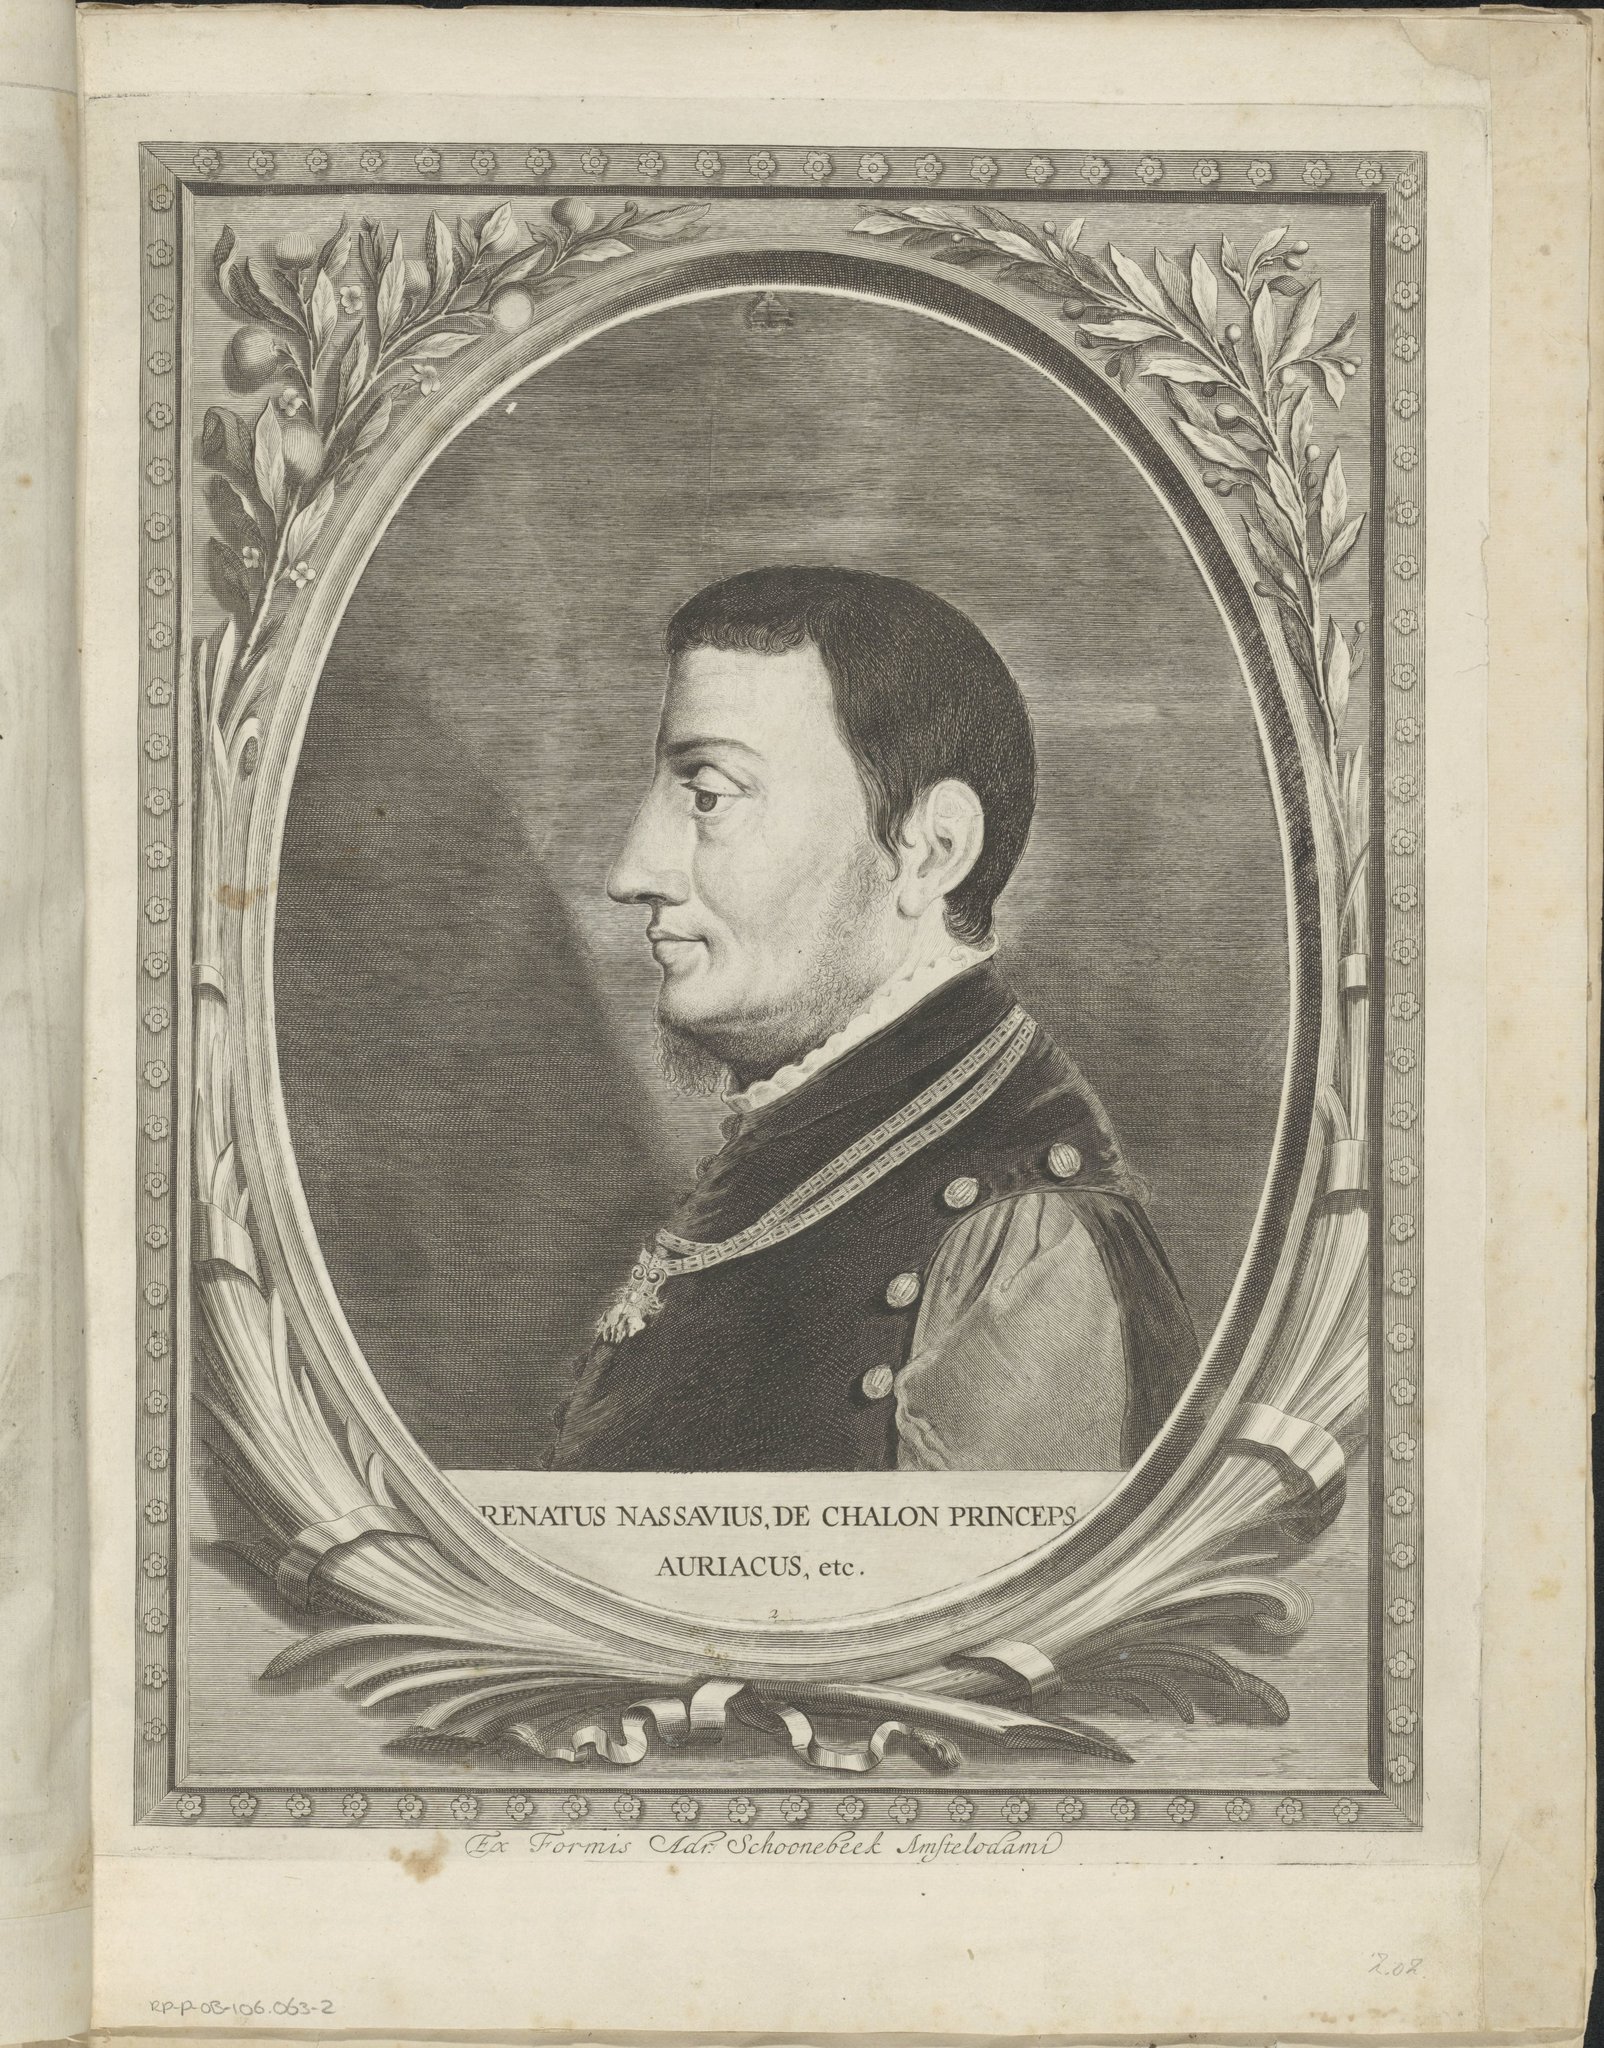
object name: print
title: Portret van René van Châlon, prins van Oranje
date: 1689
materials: paper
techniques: engraving, etching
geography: low countries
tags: knighthood order of the golden fleece - insignia of a knighthood order, e.g.: badge, chain (with name of order)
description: De hier vermelde titel verwijst naar de hoogst verkregen titel van de geportretteerde, niet per se naar de titel die de geportretteerde op deze voorstelling draagt.